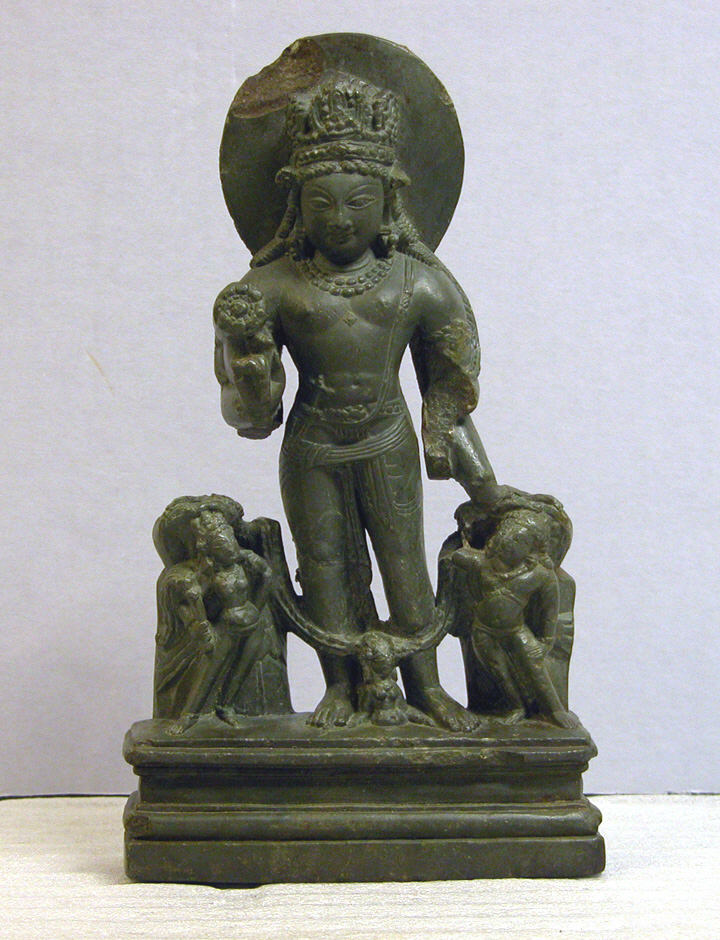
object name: group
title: Vishnu with his Personified Attributes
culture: kashmiri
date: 801-900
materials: stone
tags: kashmir,vishnu,hinduism